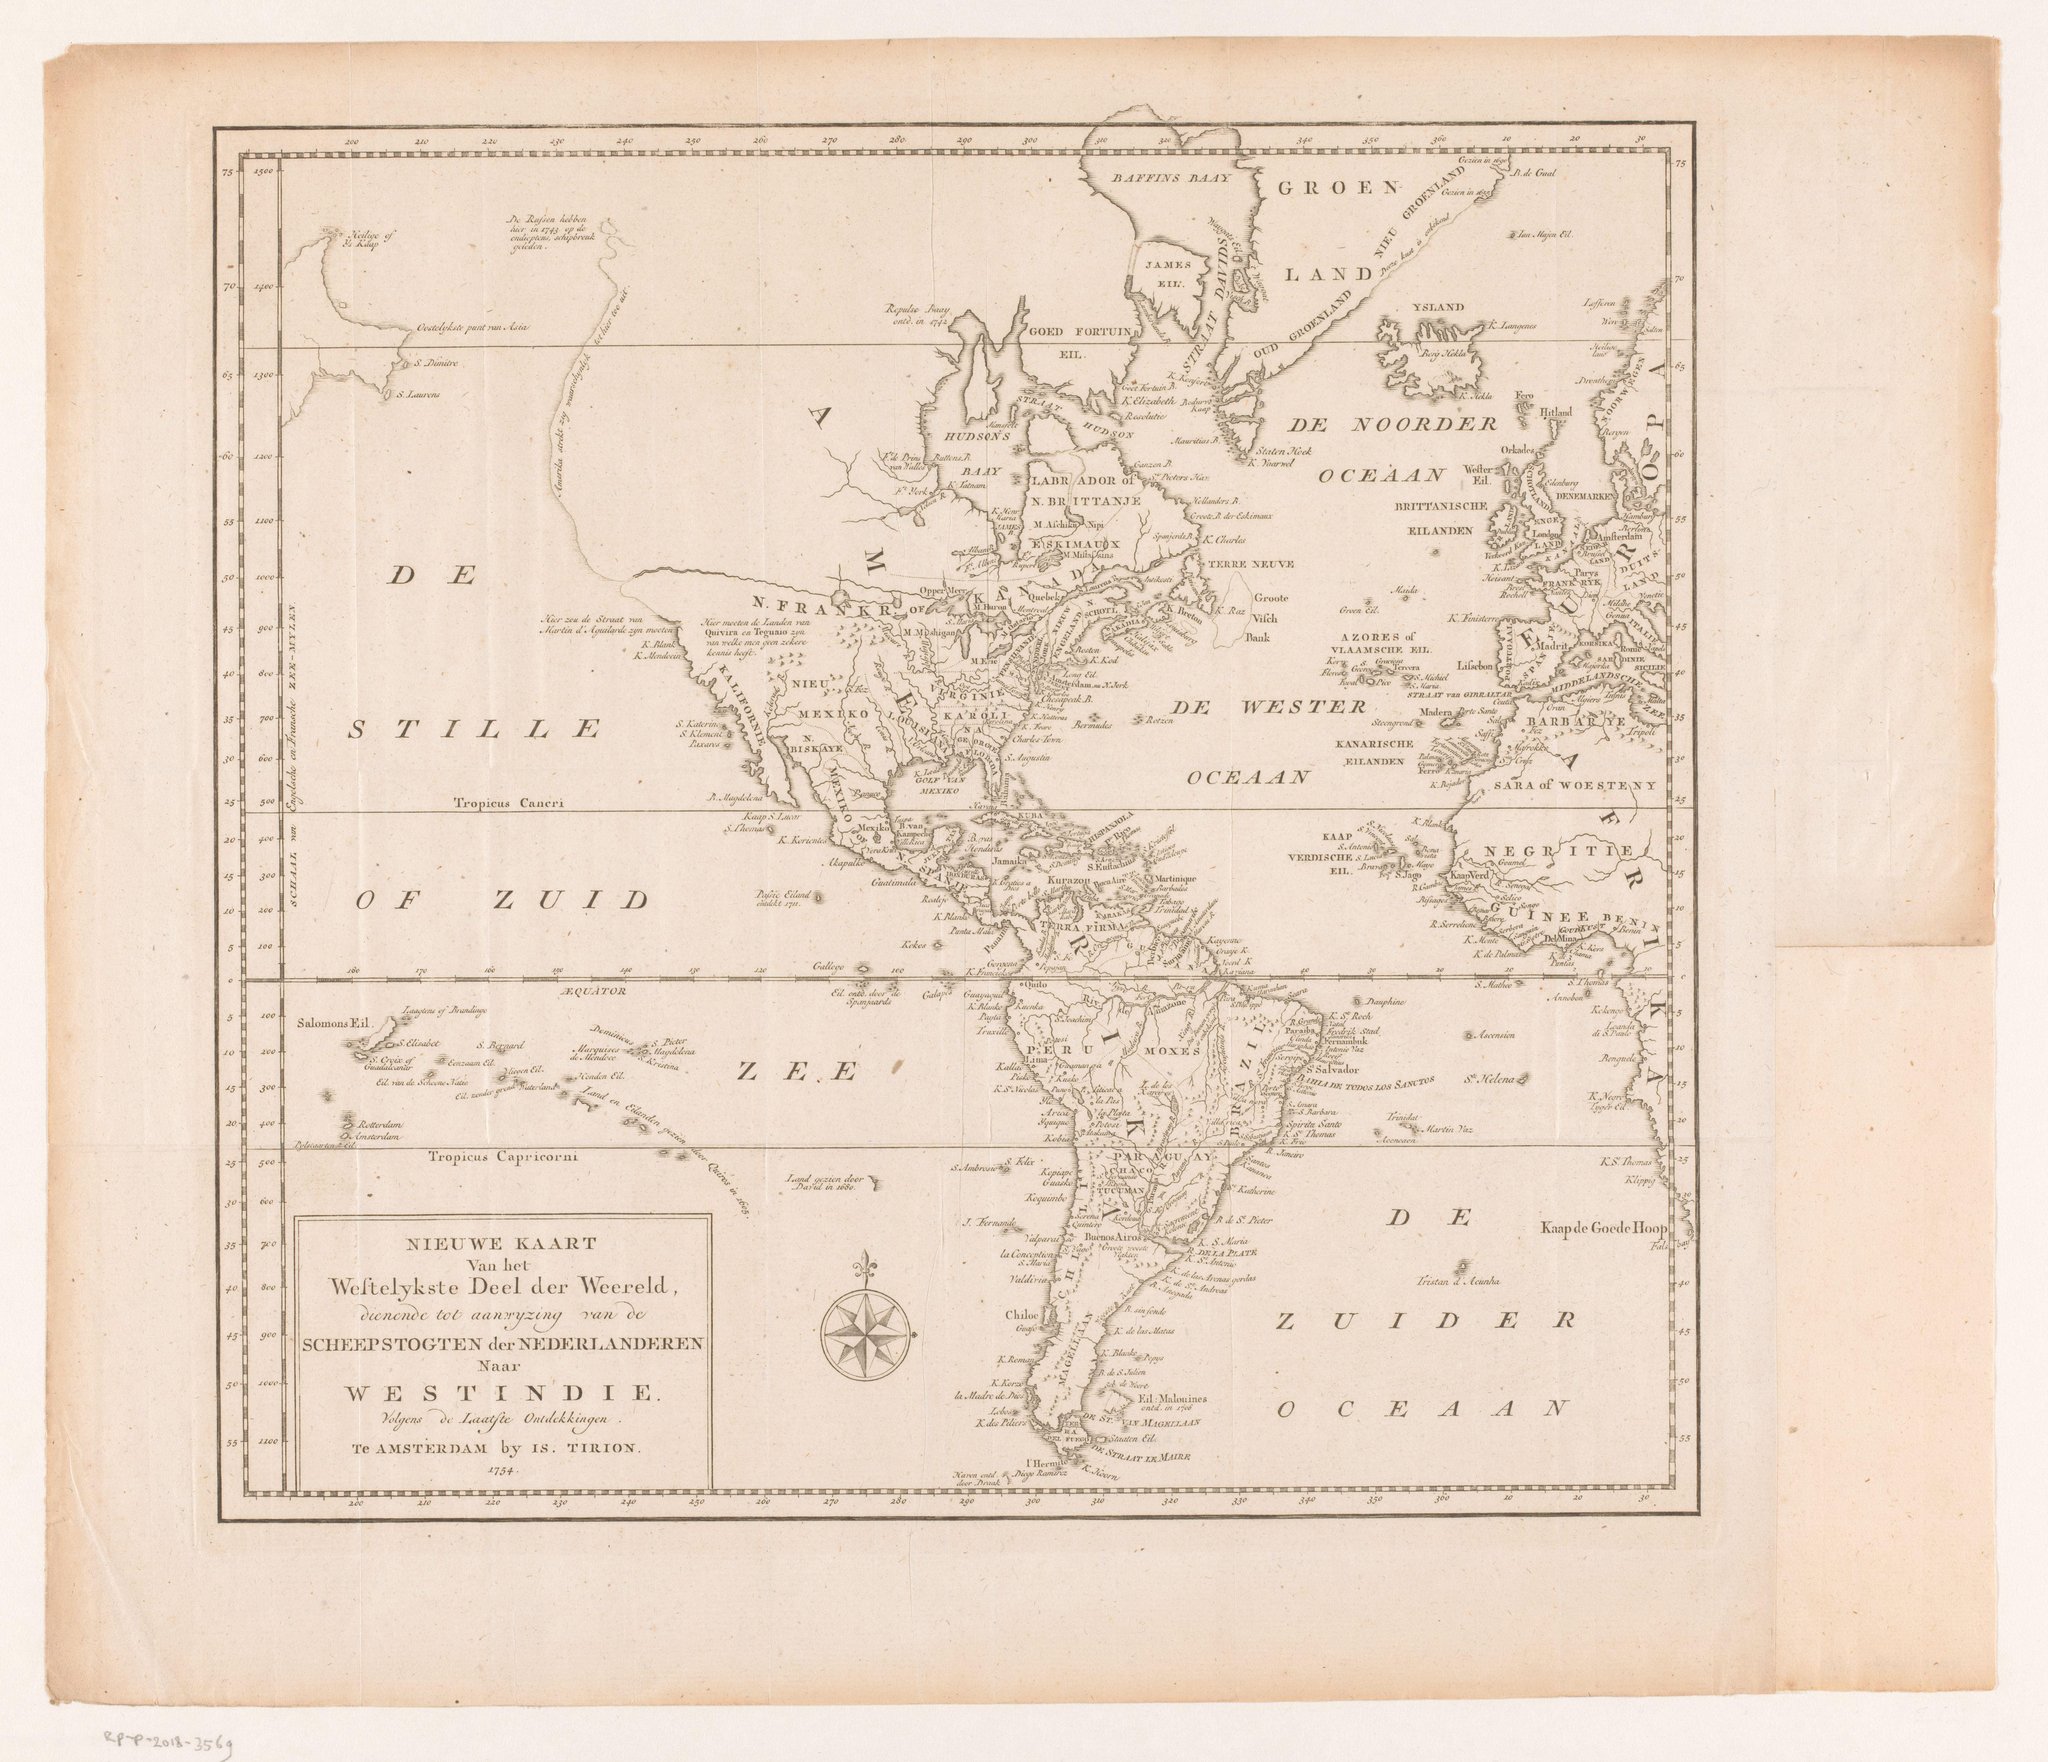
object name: print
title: Nieuwe kaart van het Westelykste Deel der Weereld, dienende tot aanwijzing van de scheepstogten der Nederlanderen naar Westindië volgens de laatste ontdekkingen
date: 1754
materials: paper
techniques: engraving, etching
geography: amsterdam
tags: maps, atlases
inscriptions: date